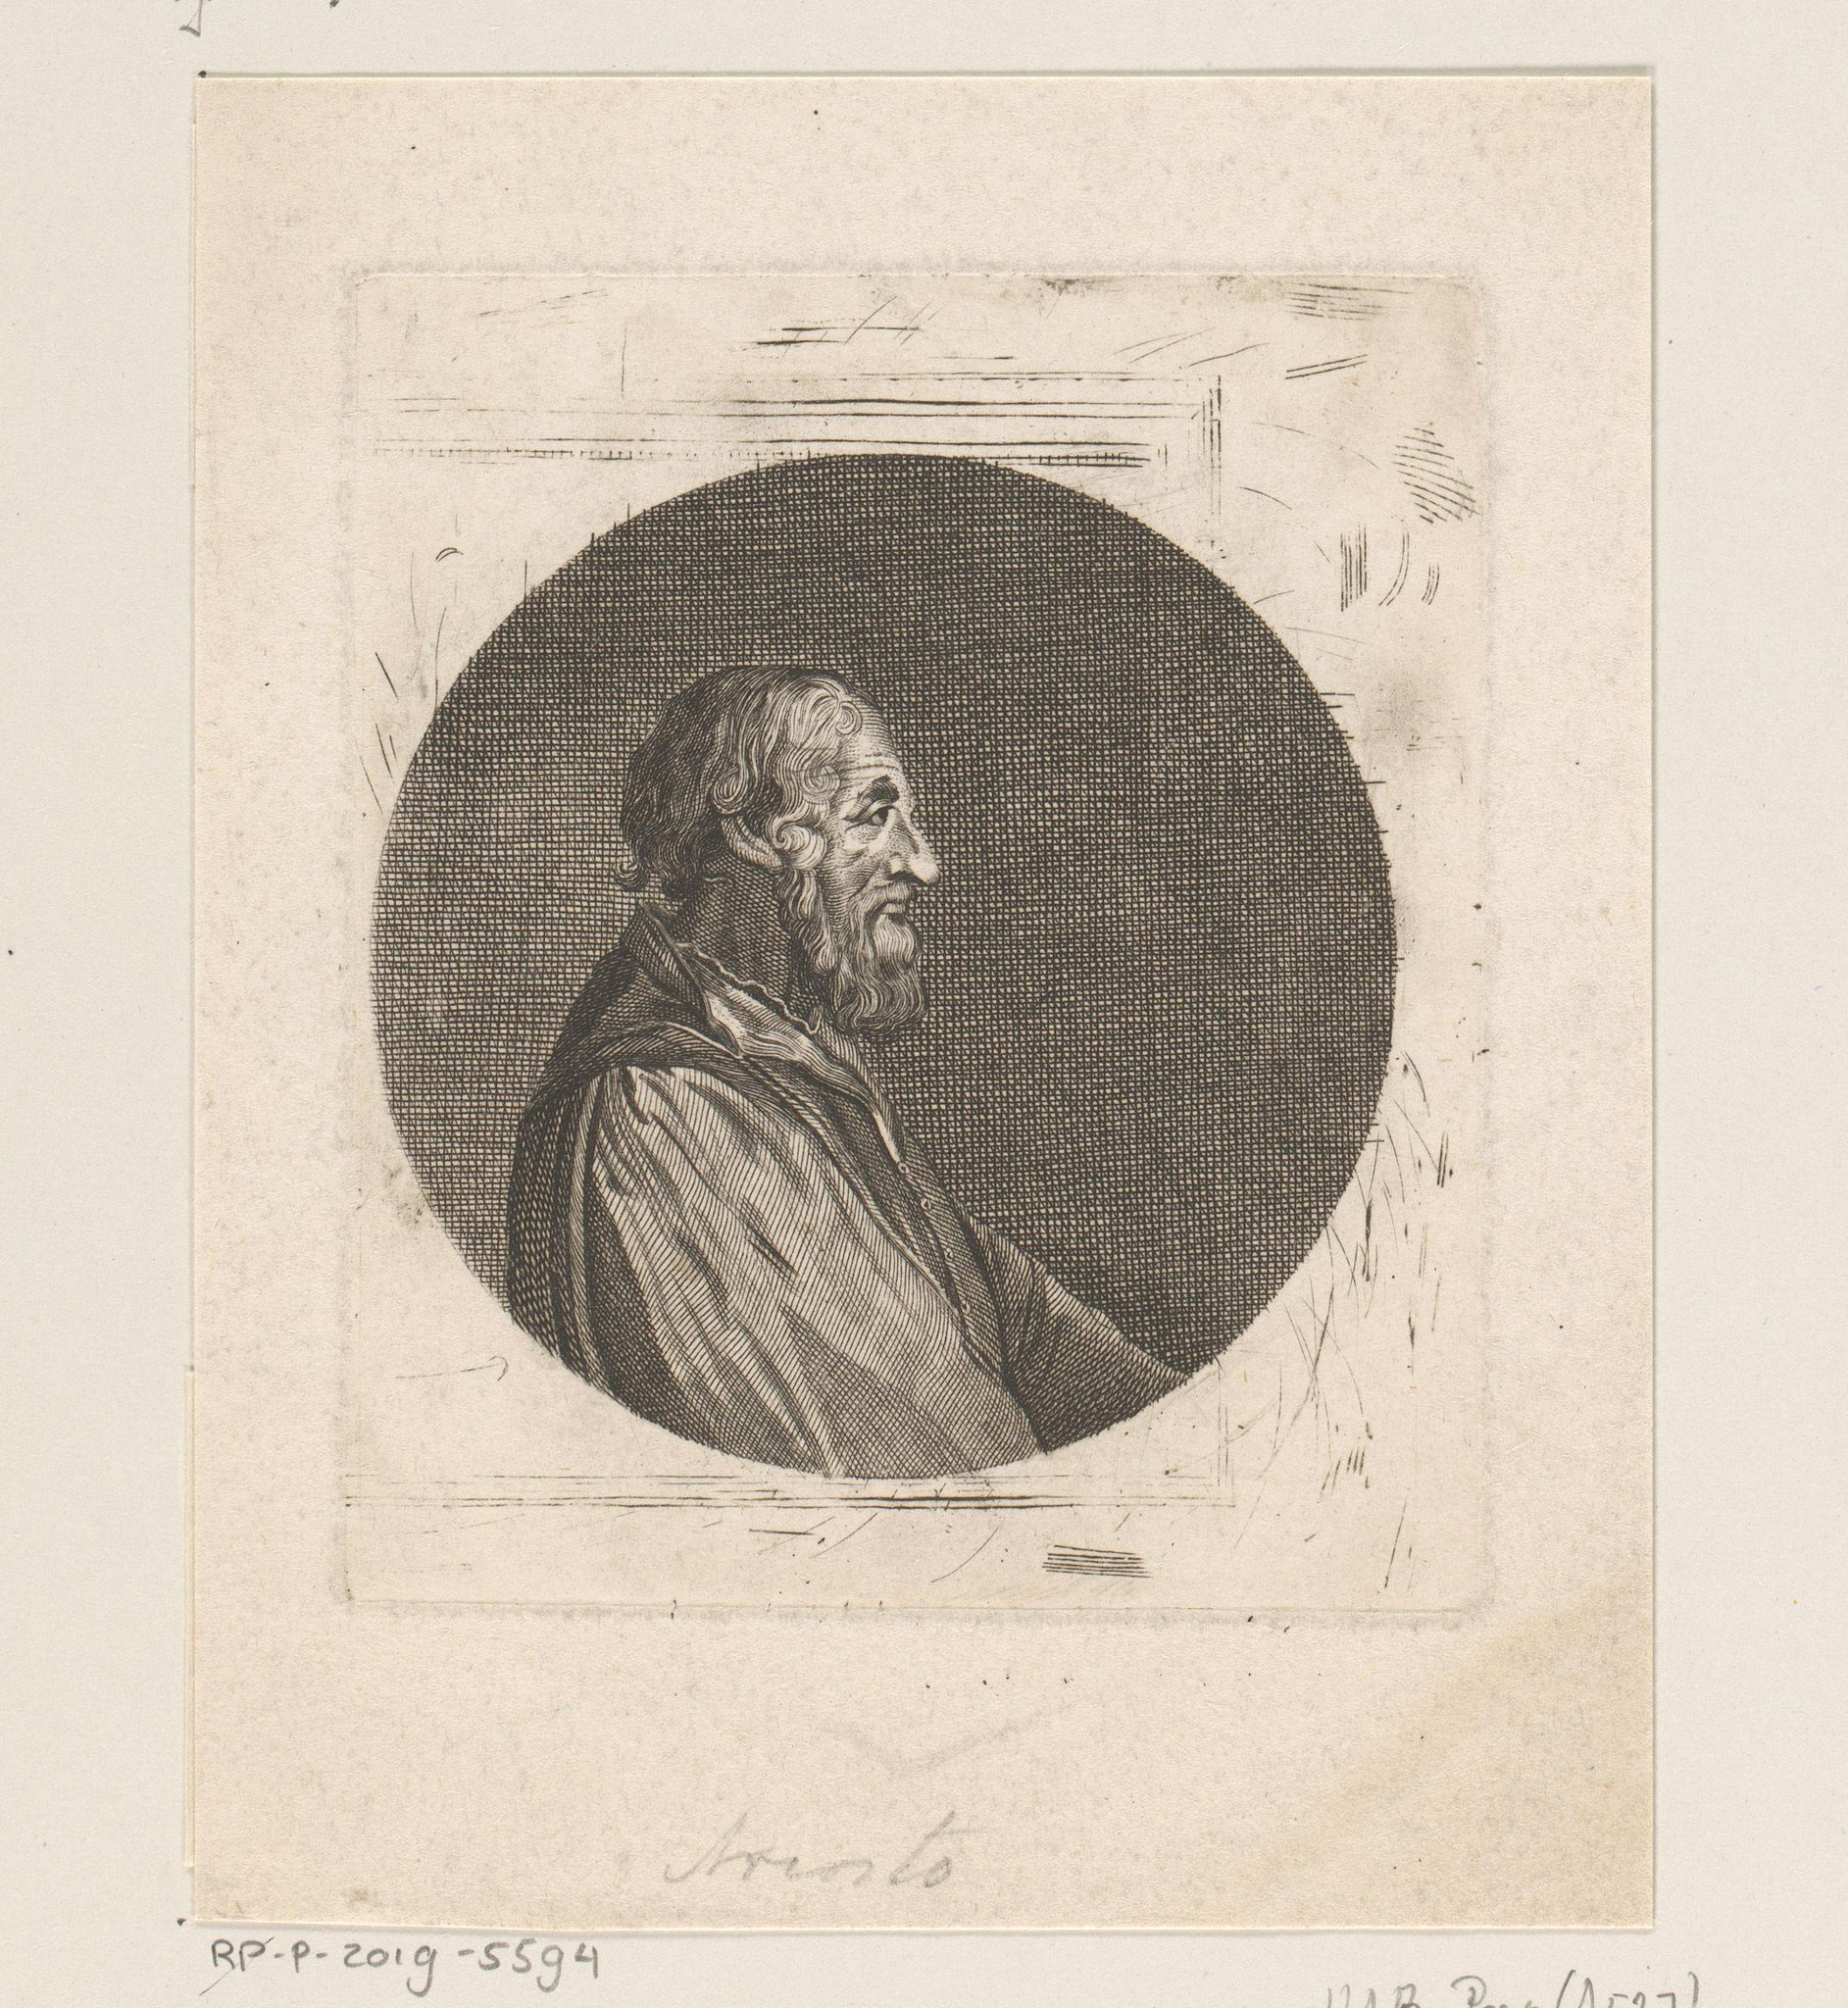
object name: print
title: Portret van Ludovico Ariosto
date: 1750-1799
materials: paper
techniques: engraving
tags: ludovico ariosto, historical persons, writer, poet, author